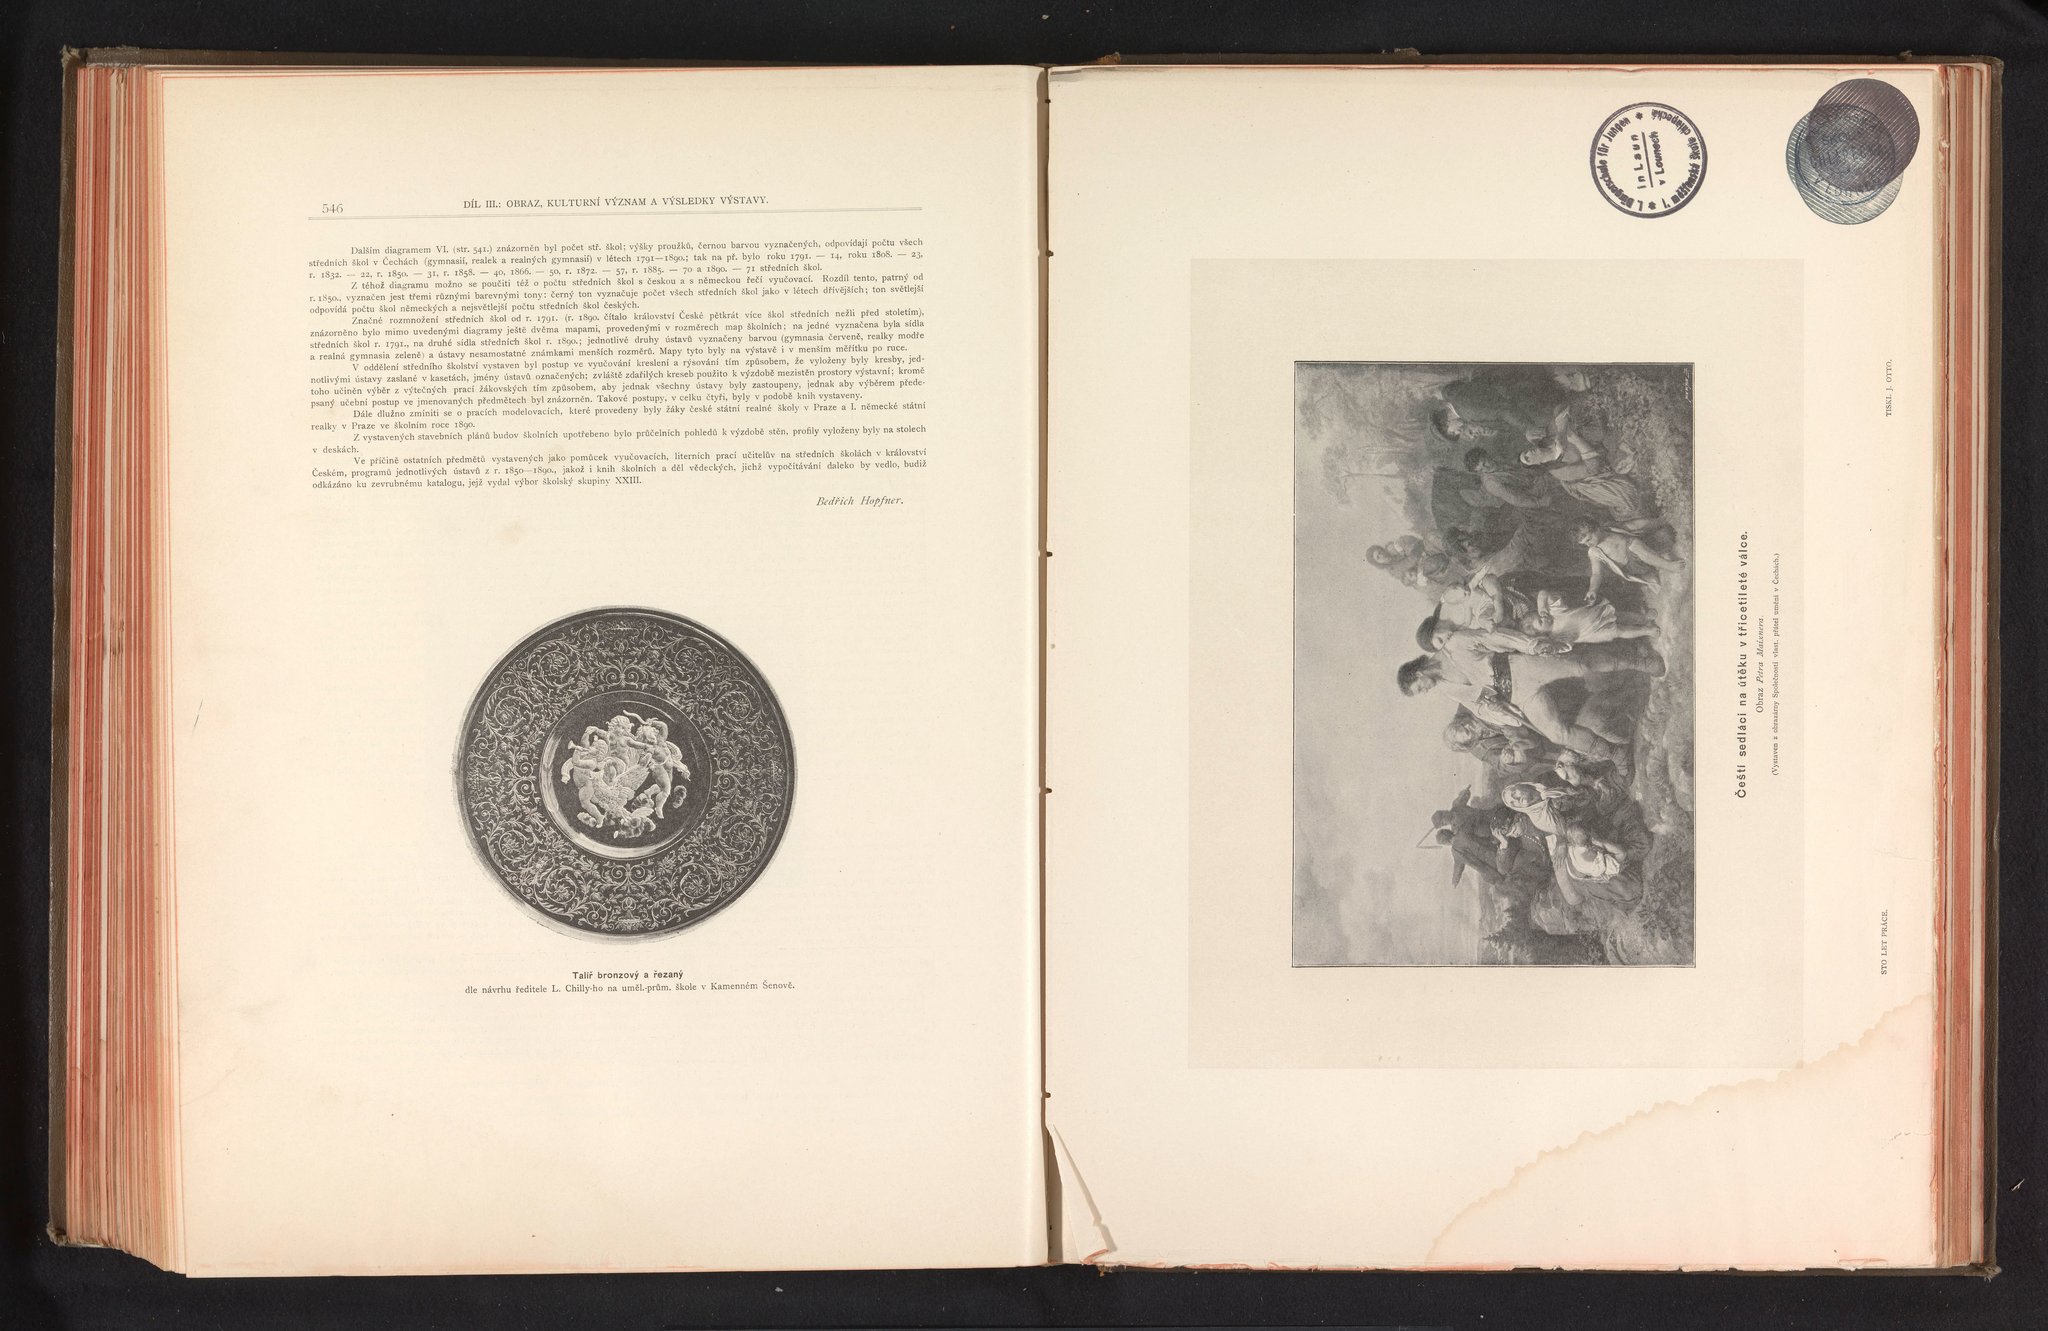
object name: page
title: Fotoreproductie van een schilderij, voorstellende Boheemse boeren op de vlucht voor de Dertigjarige Oorlog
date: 1891-1895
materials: paper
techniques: autotype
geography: prague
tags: farmers, consequences of war